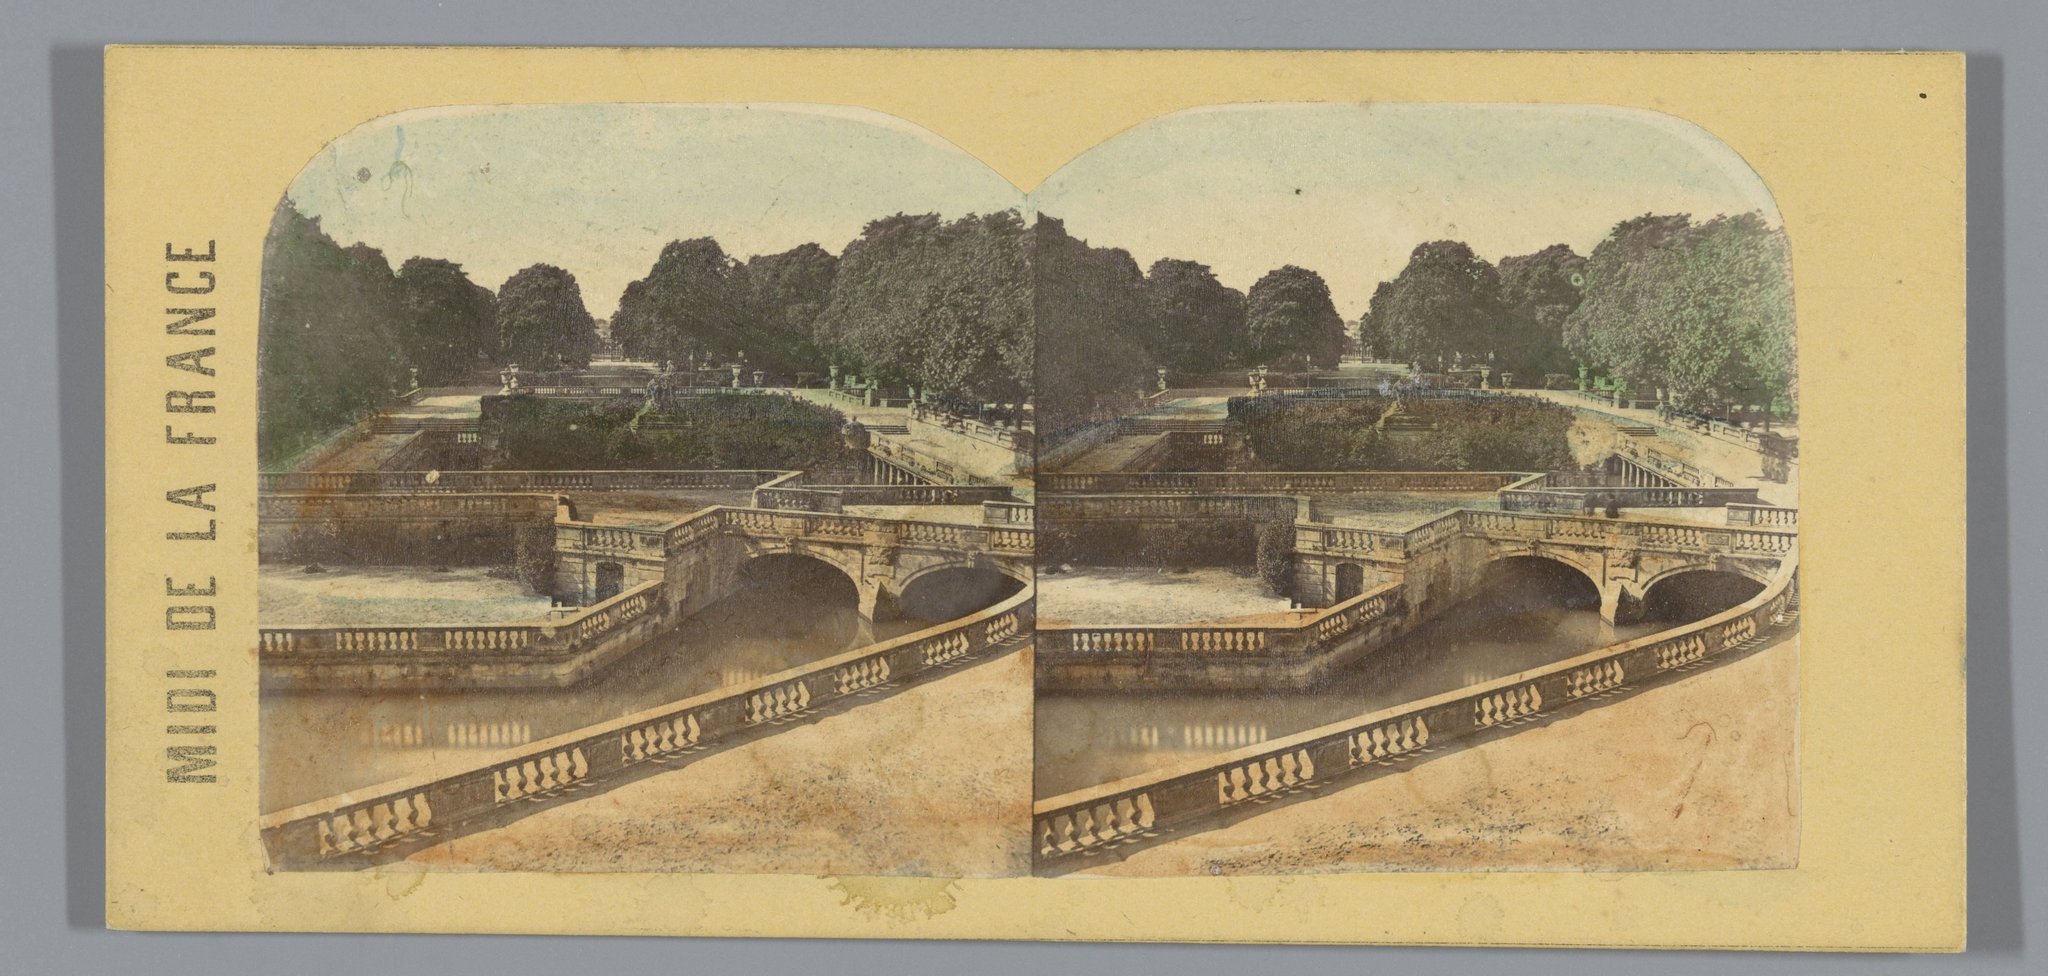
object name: stereograph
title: Gezicht op een park in vermoedelijk Montpellier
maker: Anonymous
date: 1850-1880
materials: cardboard, photographic support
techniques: albumen print, hand coloring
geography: montpellier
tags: public gardens, park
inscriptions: inscription: ‘Jardin Supérieur, Montpellier’